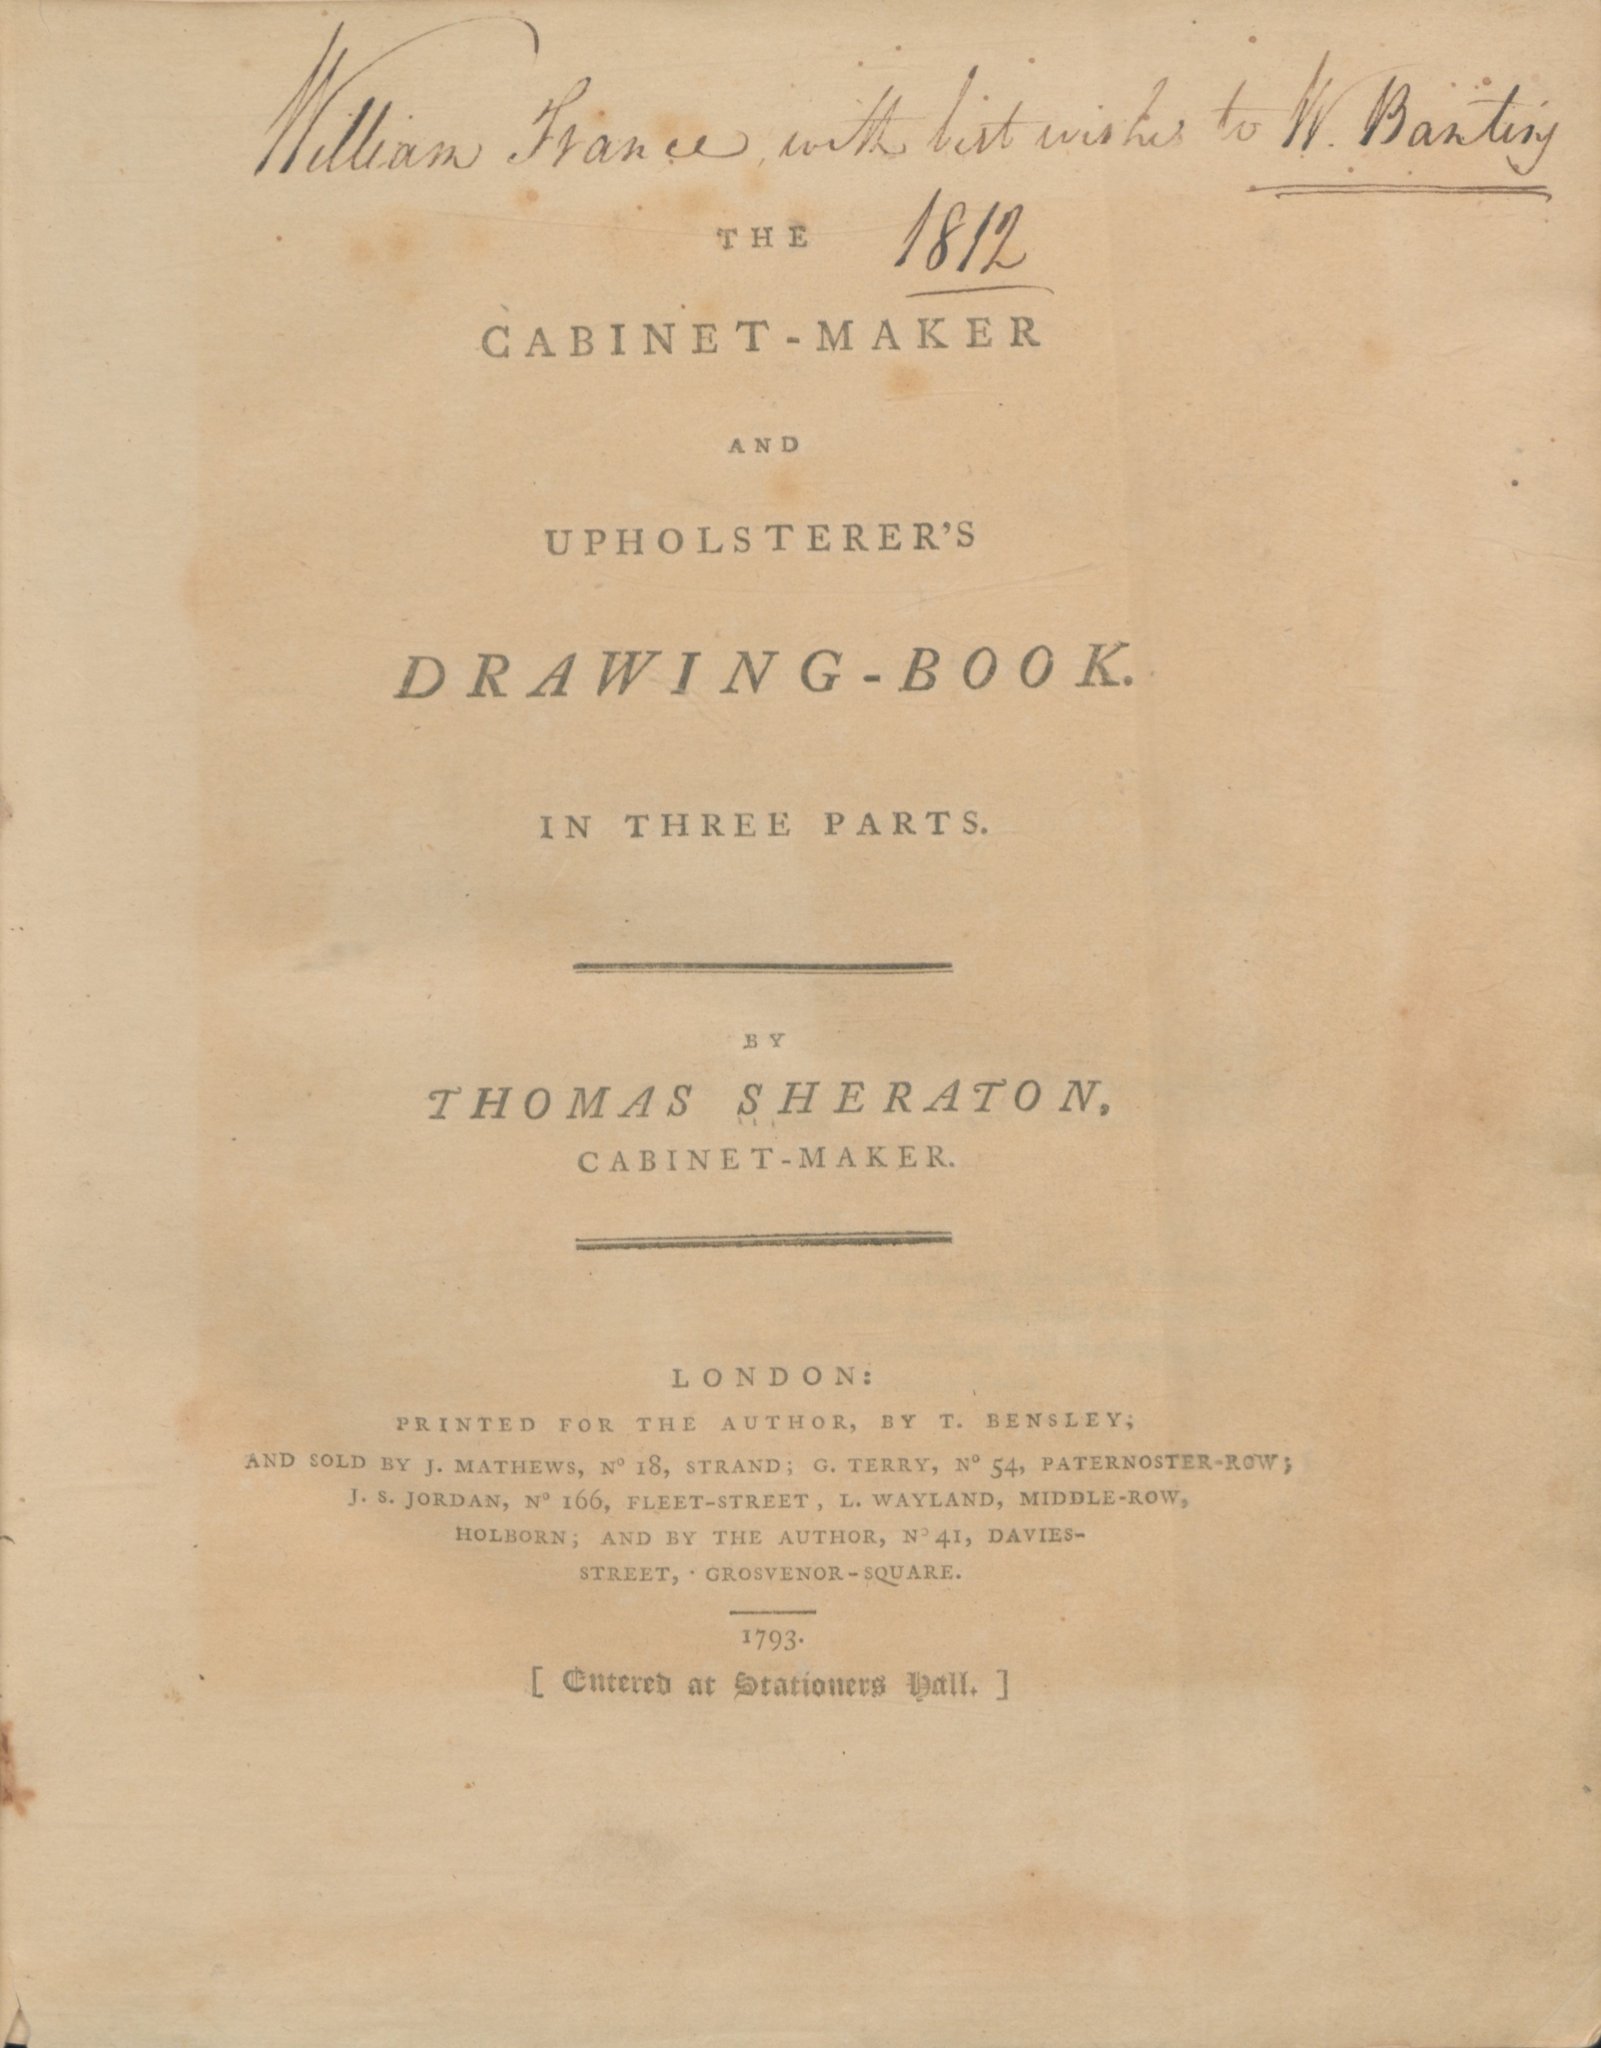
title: The cabinet-maker and upholsterer's drawing-book, in three parts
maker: thomas sheraton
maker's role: author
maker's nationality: british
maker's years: 1751-1806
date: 1793-1794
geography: london